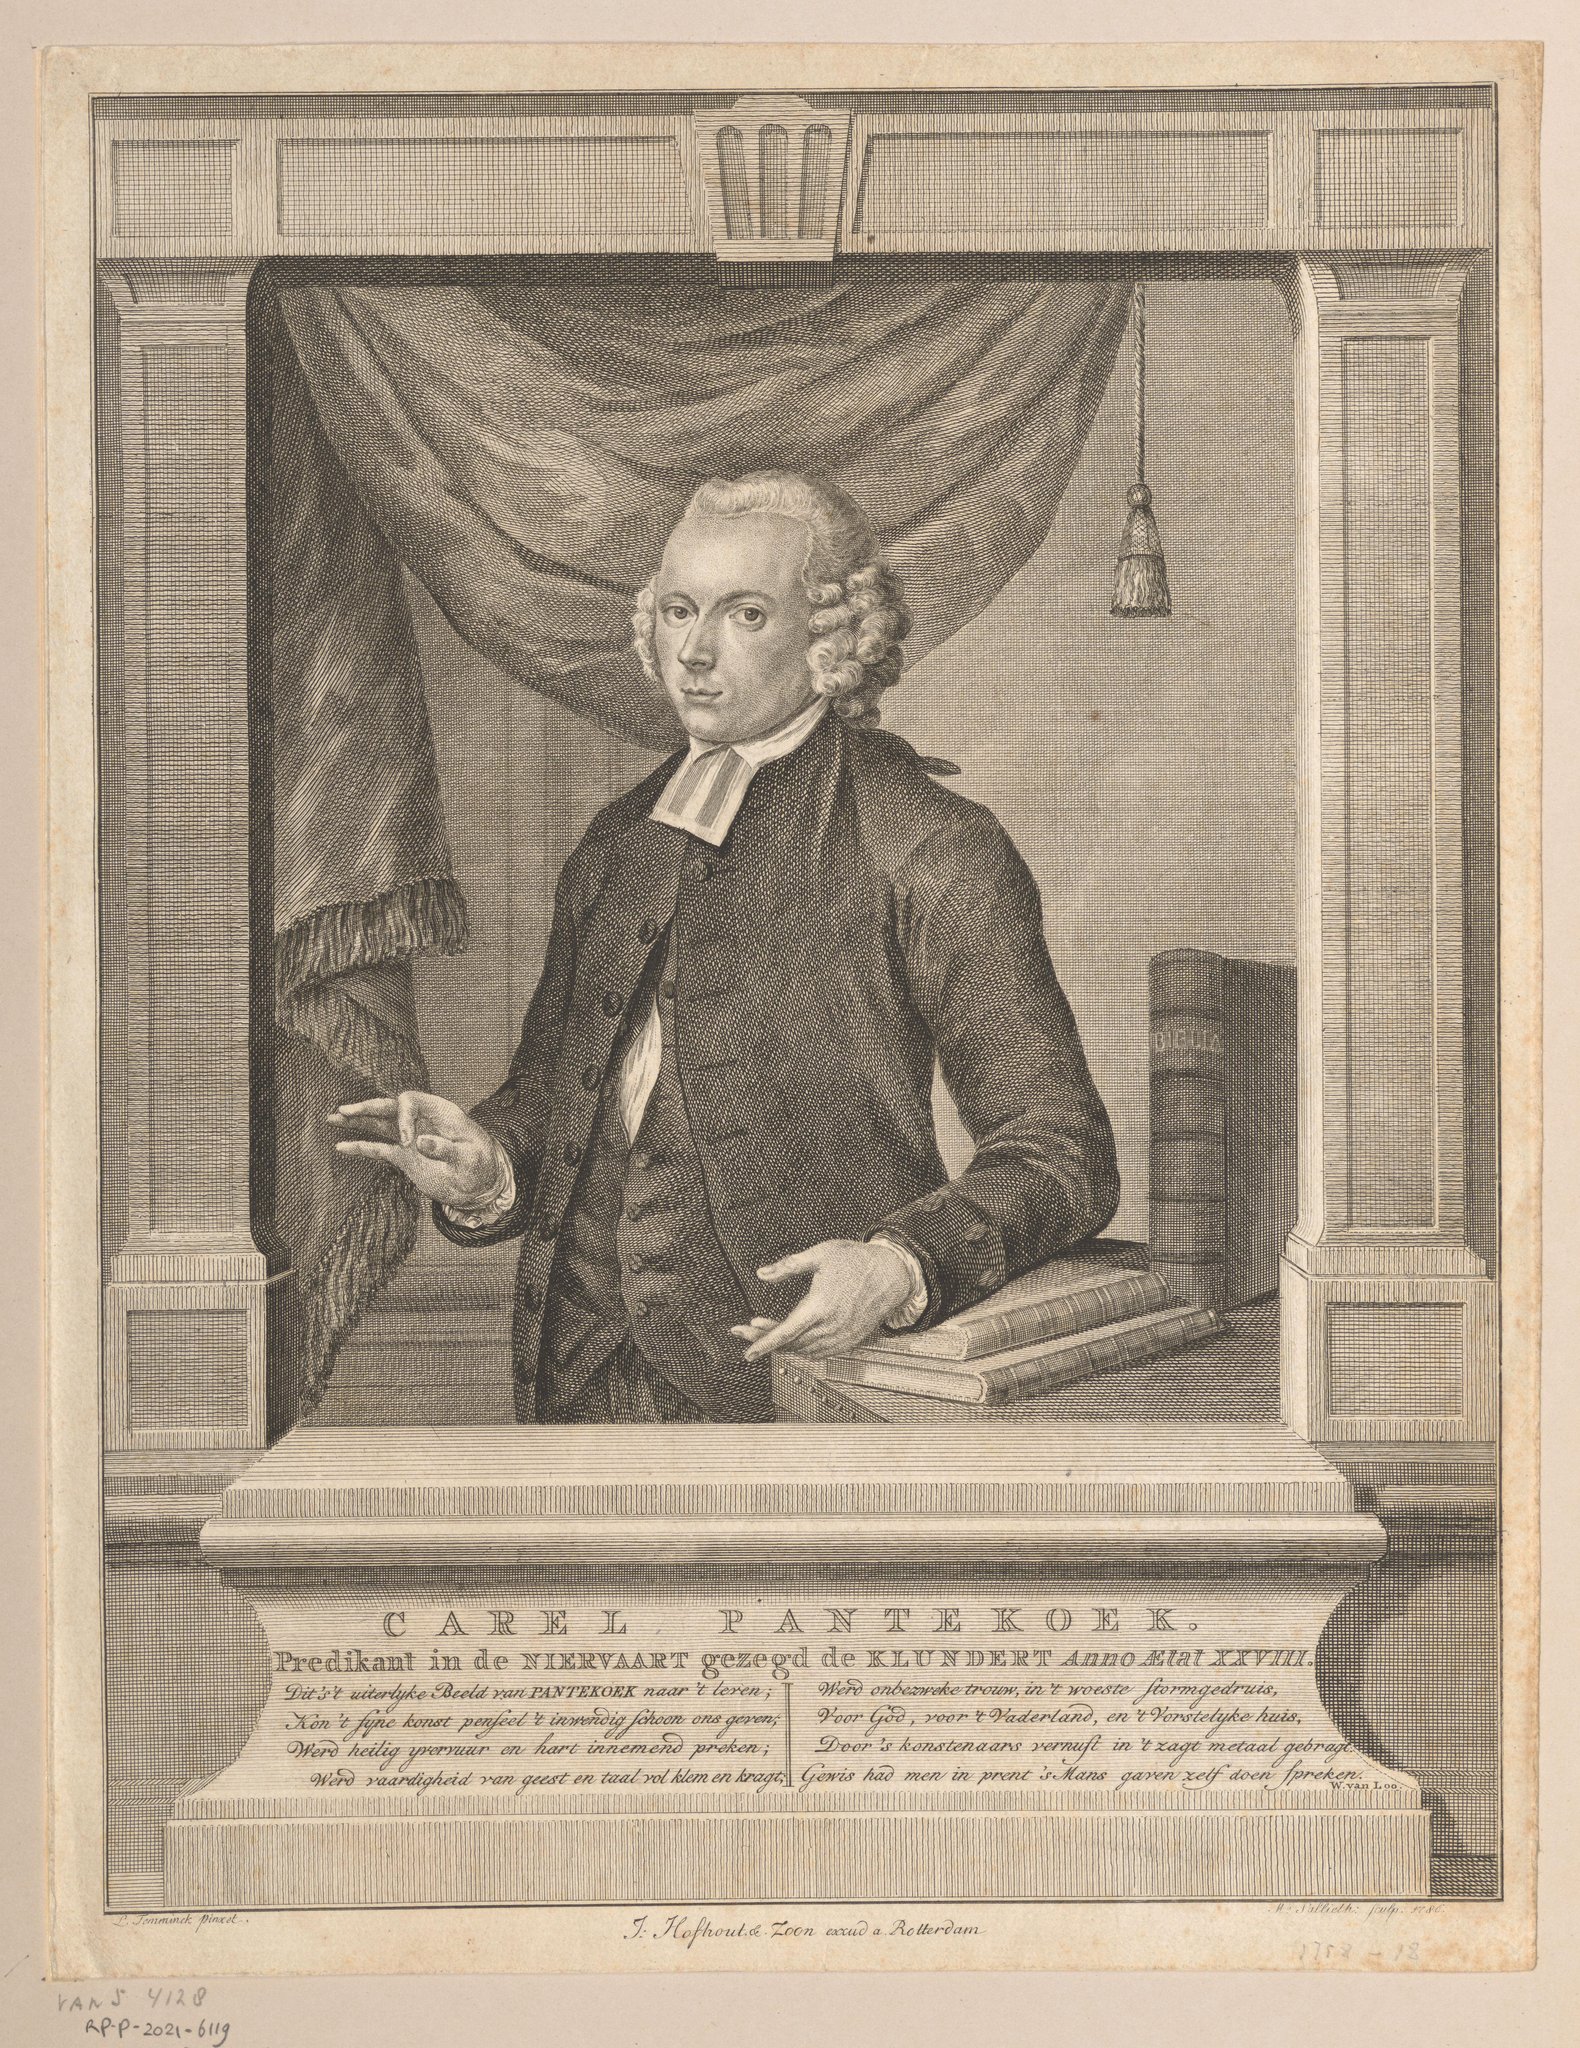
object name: print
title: Portret van Carolus Pantekoek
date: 1786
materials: paper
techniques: engraving, etching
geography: rotterdam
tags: carolus pantekoek, adult man, historical persons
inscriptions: collector's mark: Lugt 2228